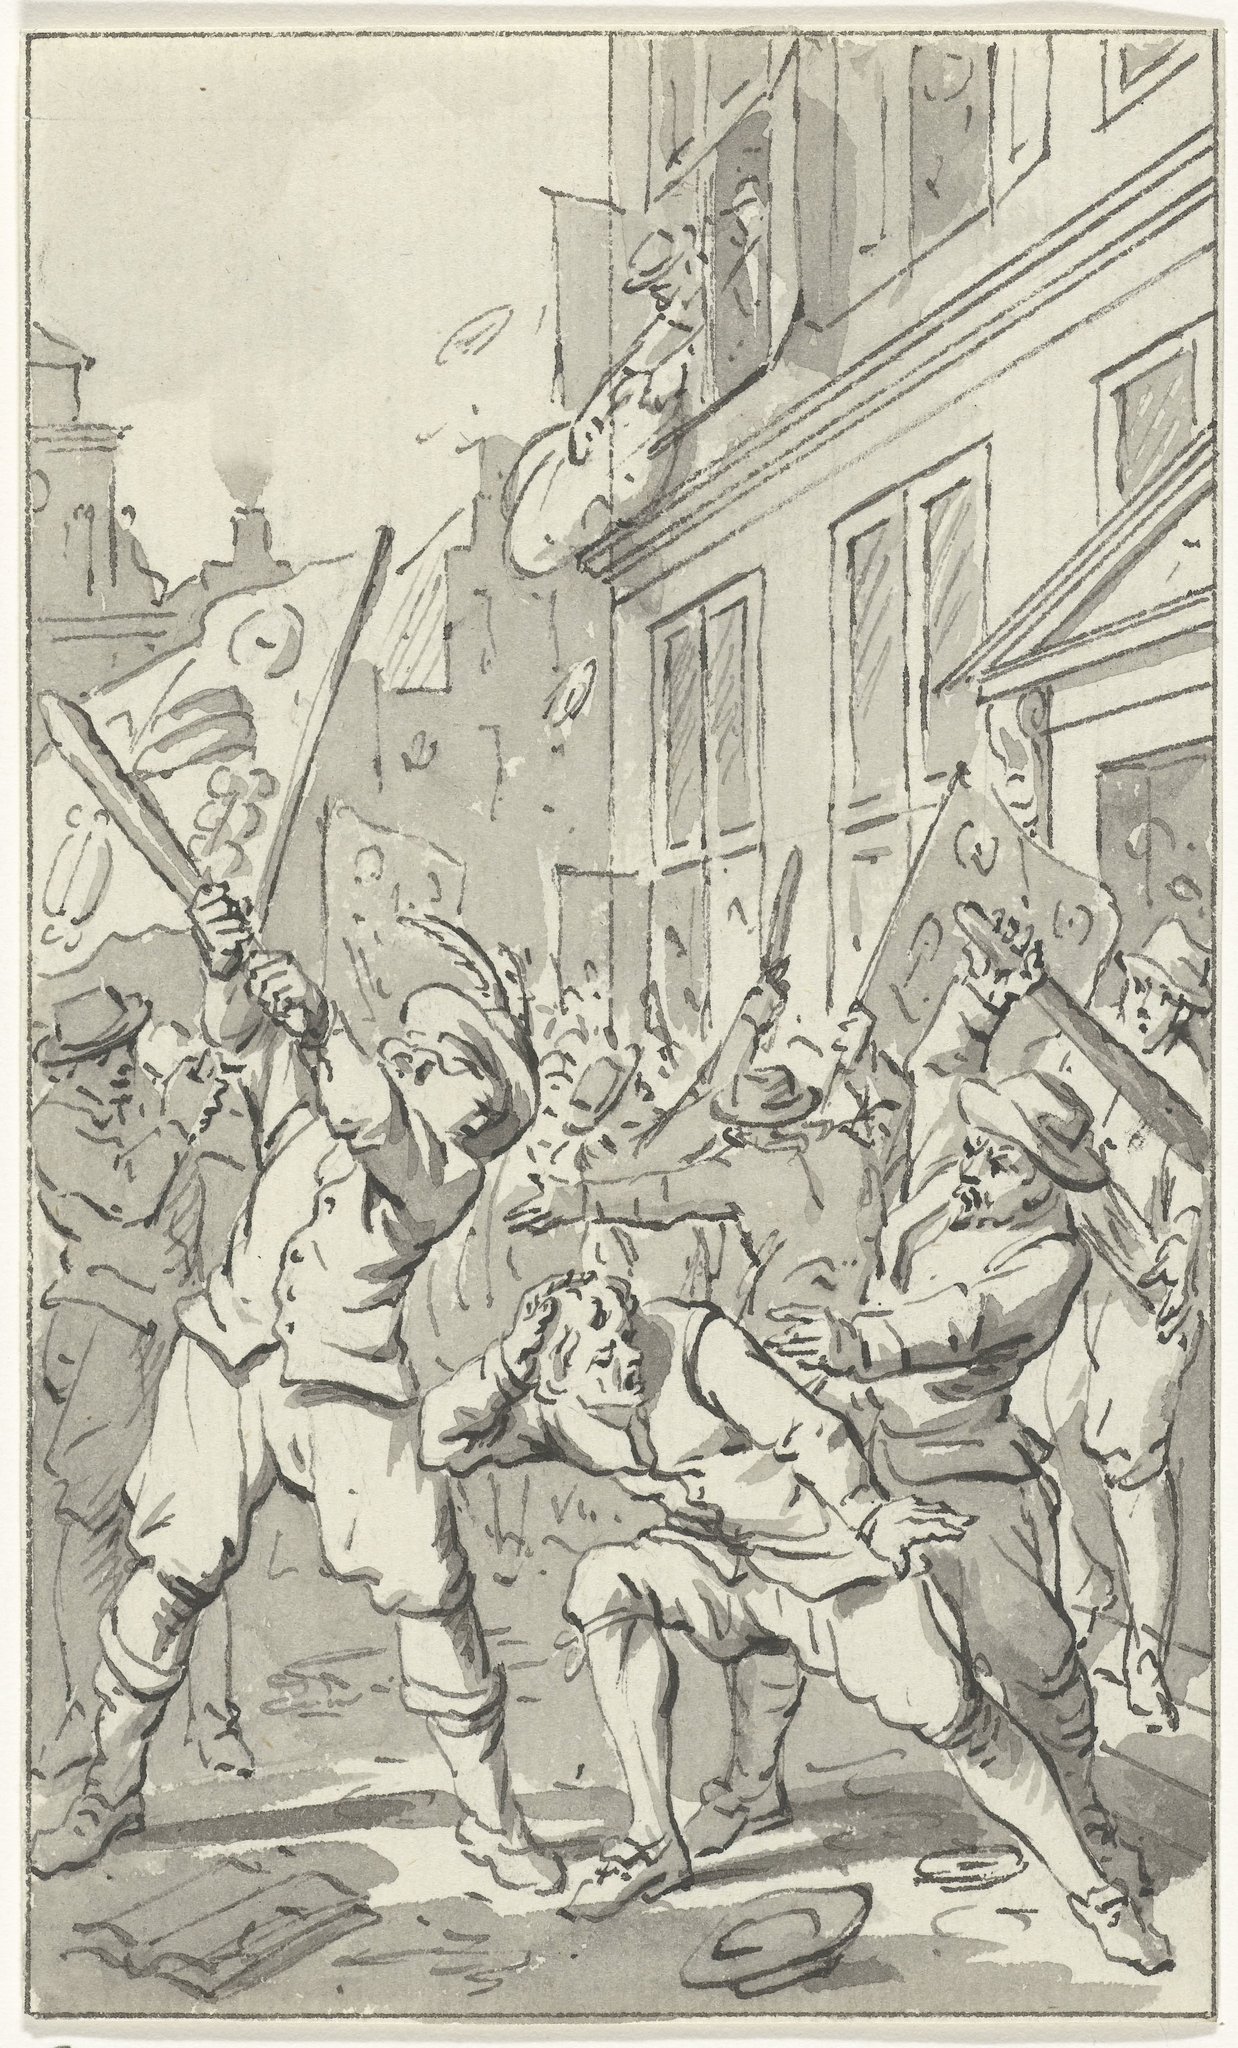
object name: design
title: Volkswoede in Alkmaar tijdens het Kaas- en Broodoproer, 1492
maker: jacobus buys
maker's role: draughtsman, print maker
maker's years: 1724-1801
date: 1783-1785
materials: ink, paper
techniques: brush, pen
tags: violent death, being killed; being mishandled and maltreated; seeking death, street-fights, riots, historical events and situations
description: Opstand van het Kaas- en Broodvolk te Alkmaar, 1492. Plundering van het huis van de rentmeester Klaas Korf en het doodslaan van zijn bediende. Ontwerp voor een prent.